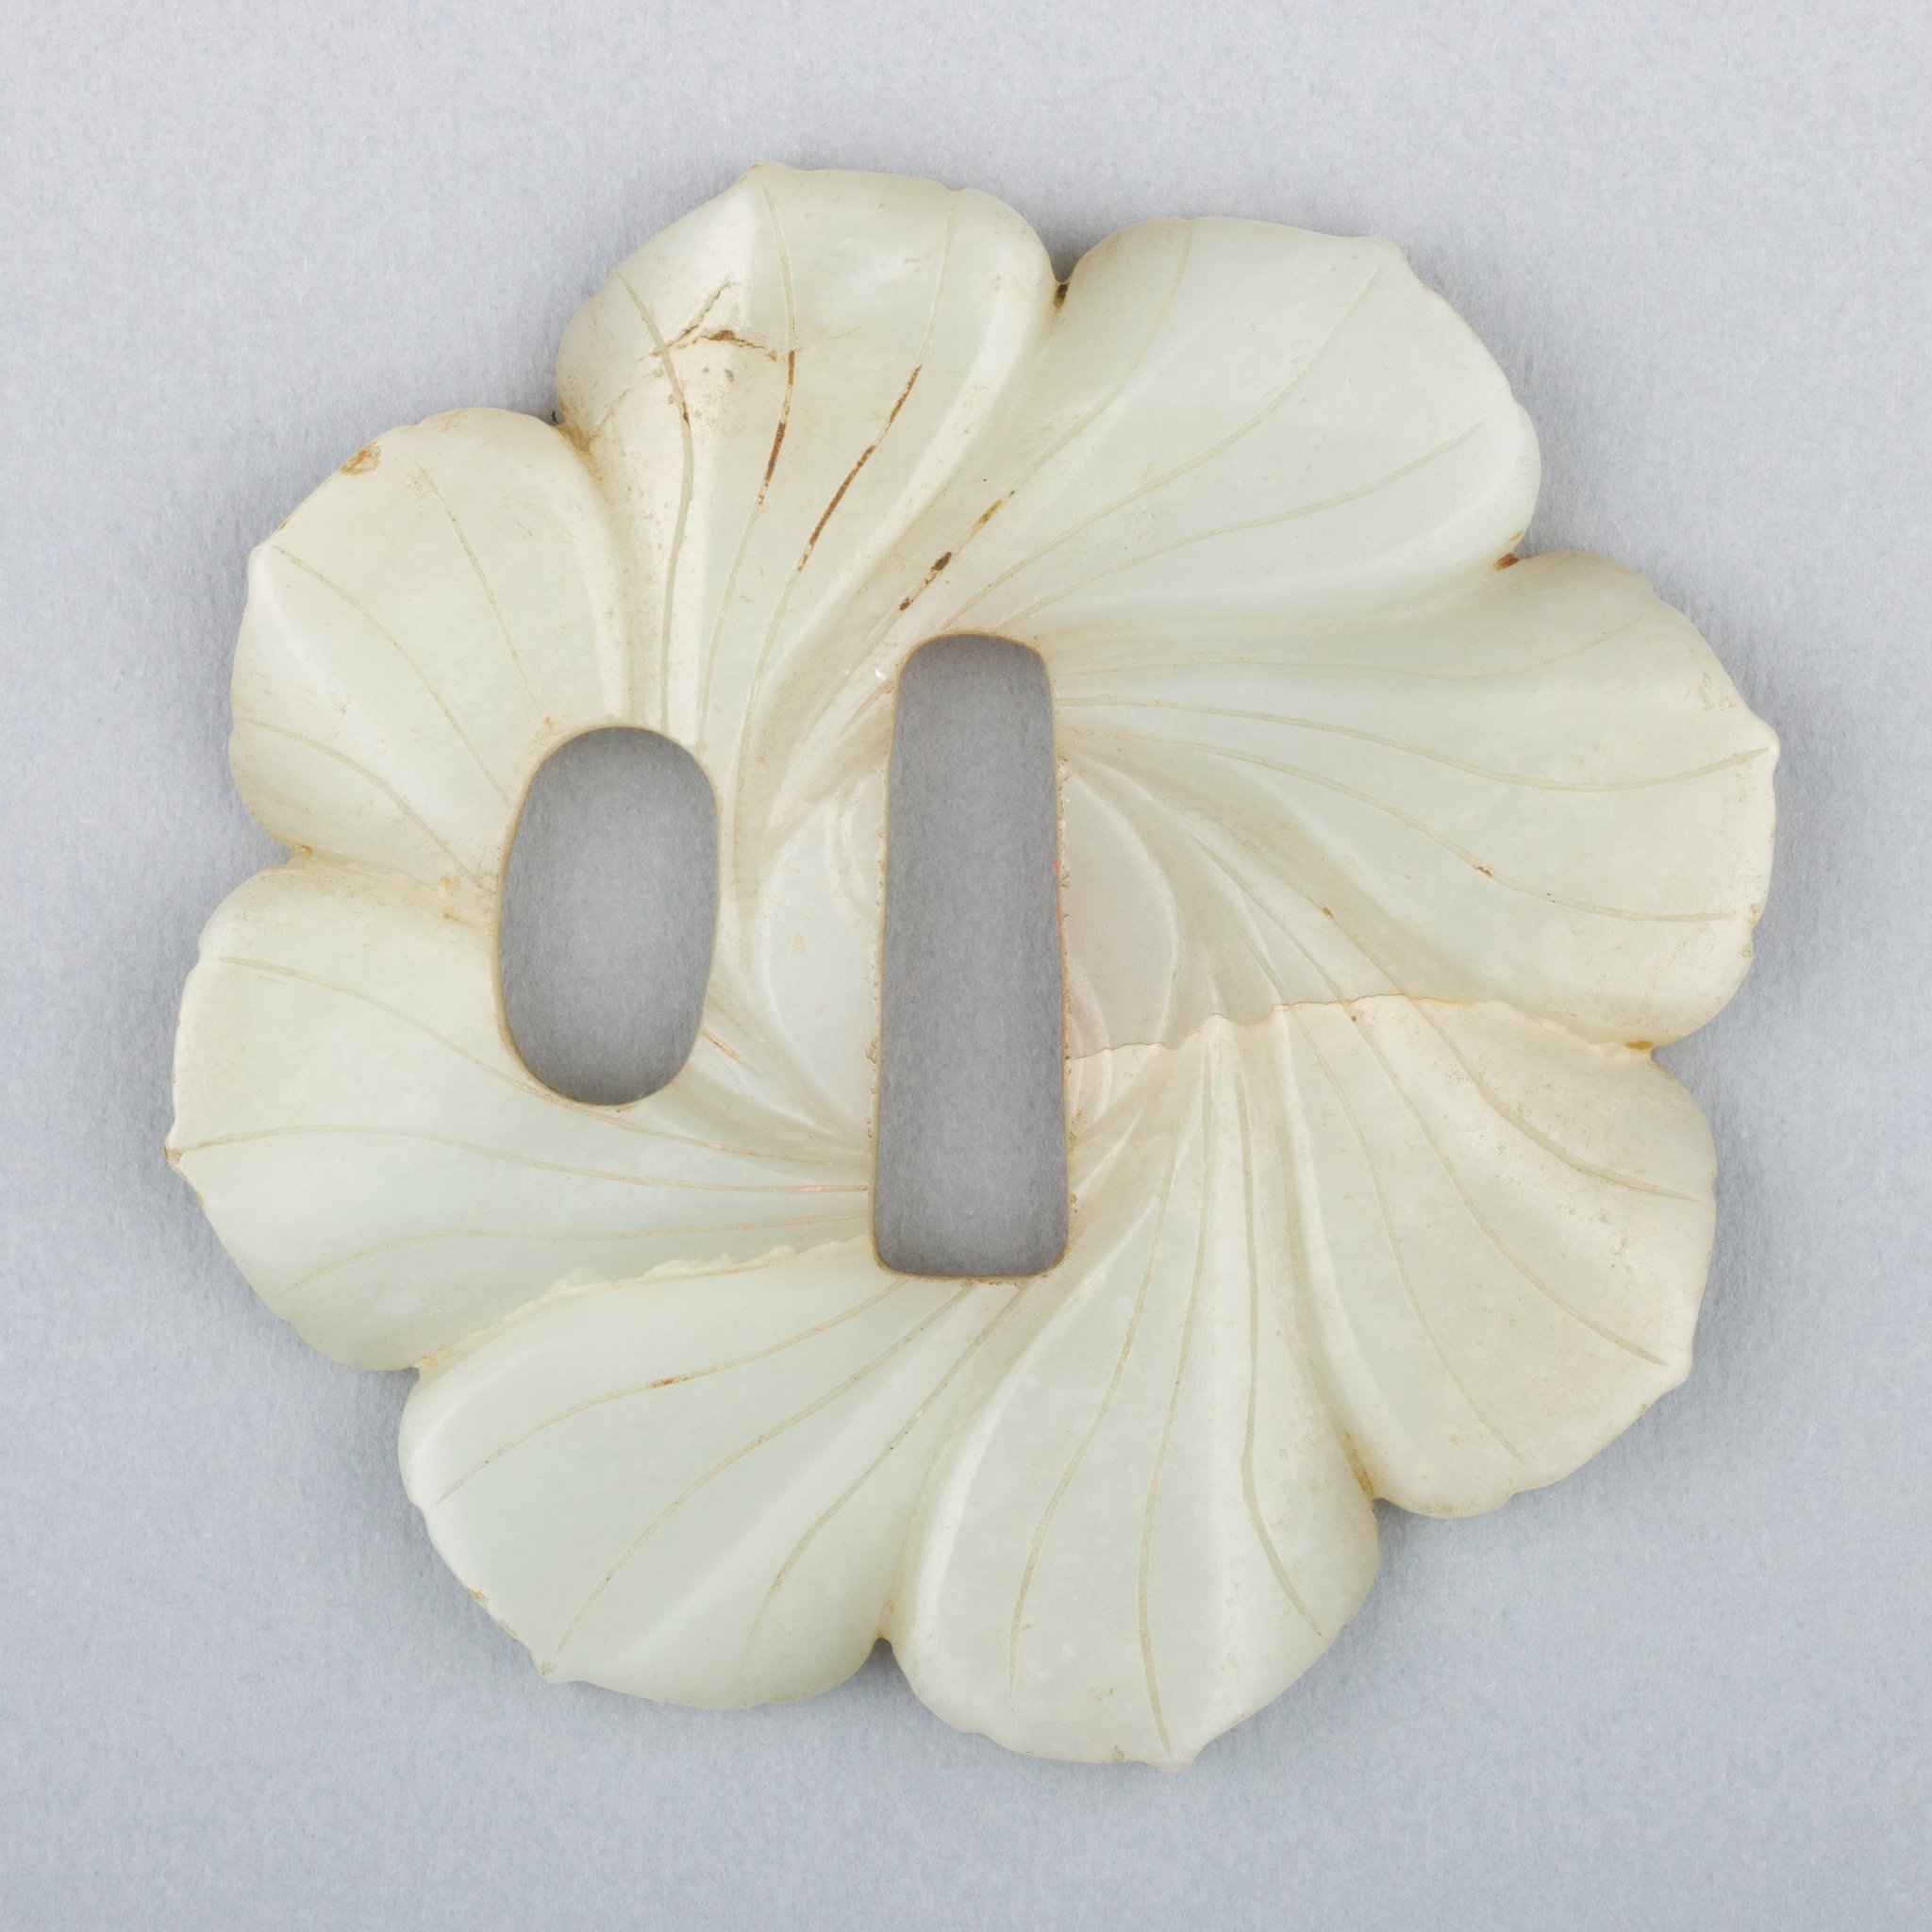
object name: sword guard tsuba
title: Sword Guard (Tsuba)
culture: japanese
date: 1800-1805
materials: copper, jade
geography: japan